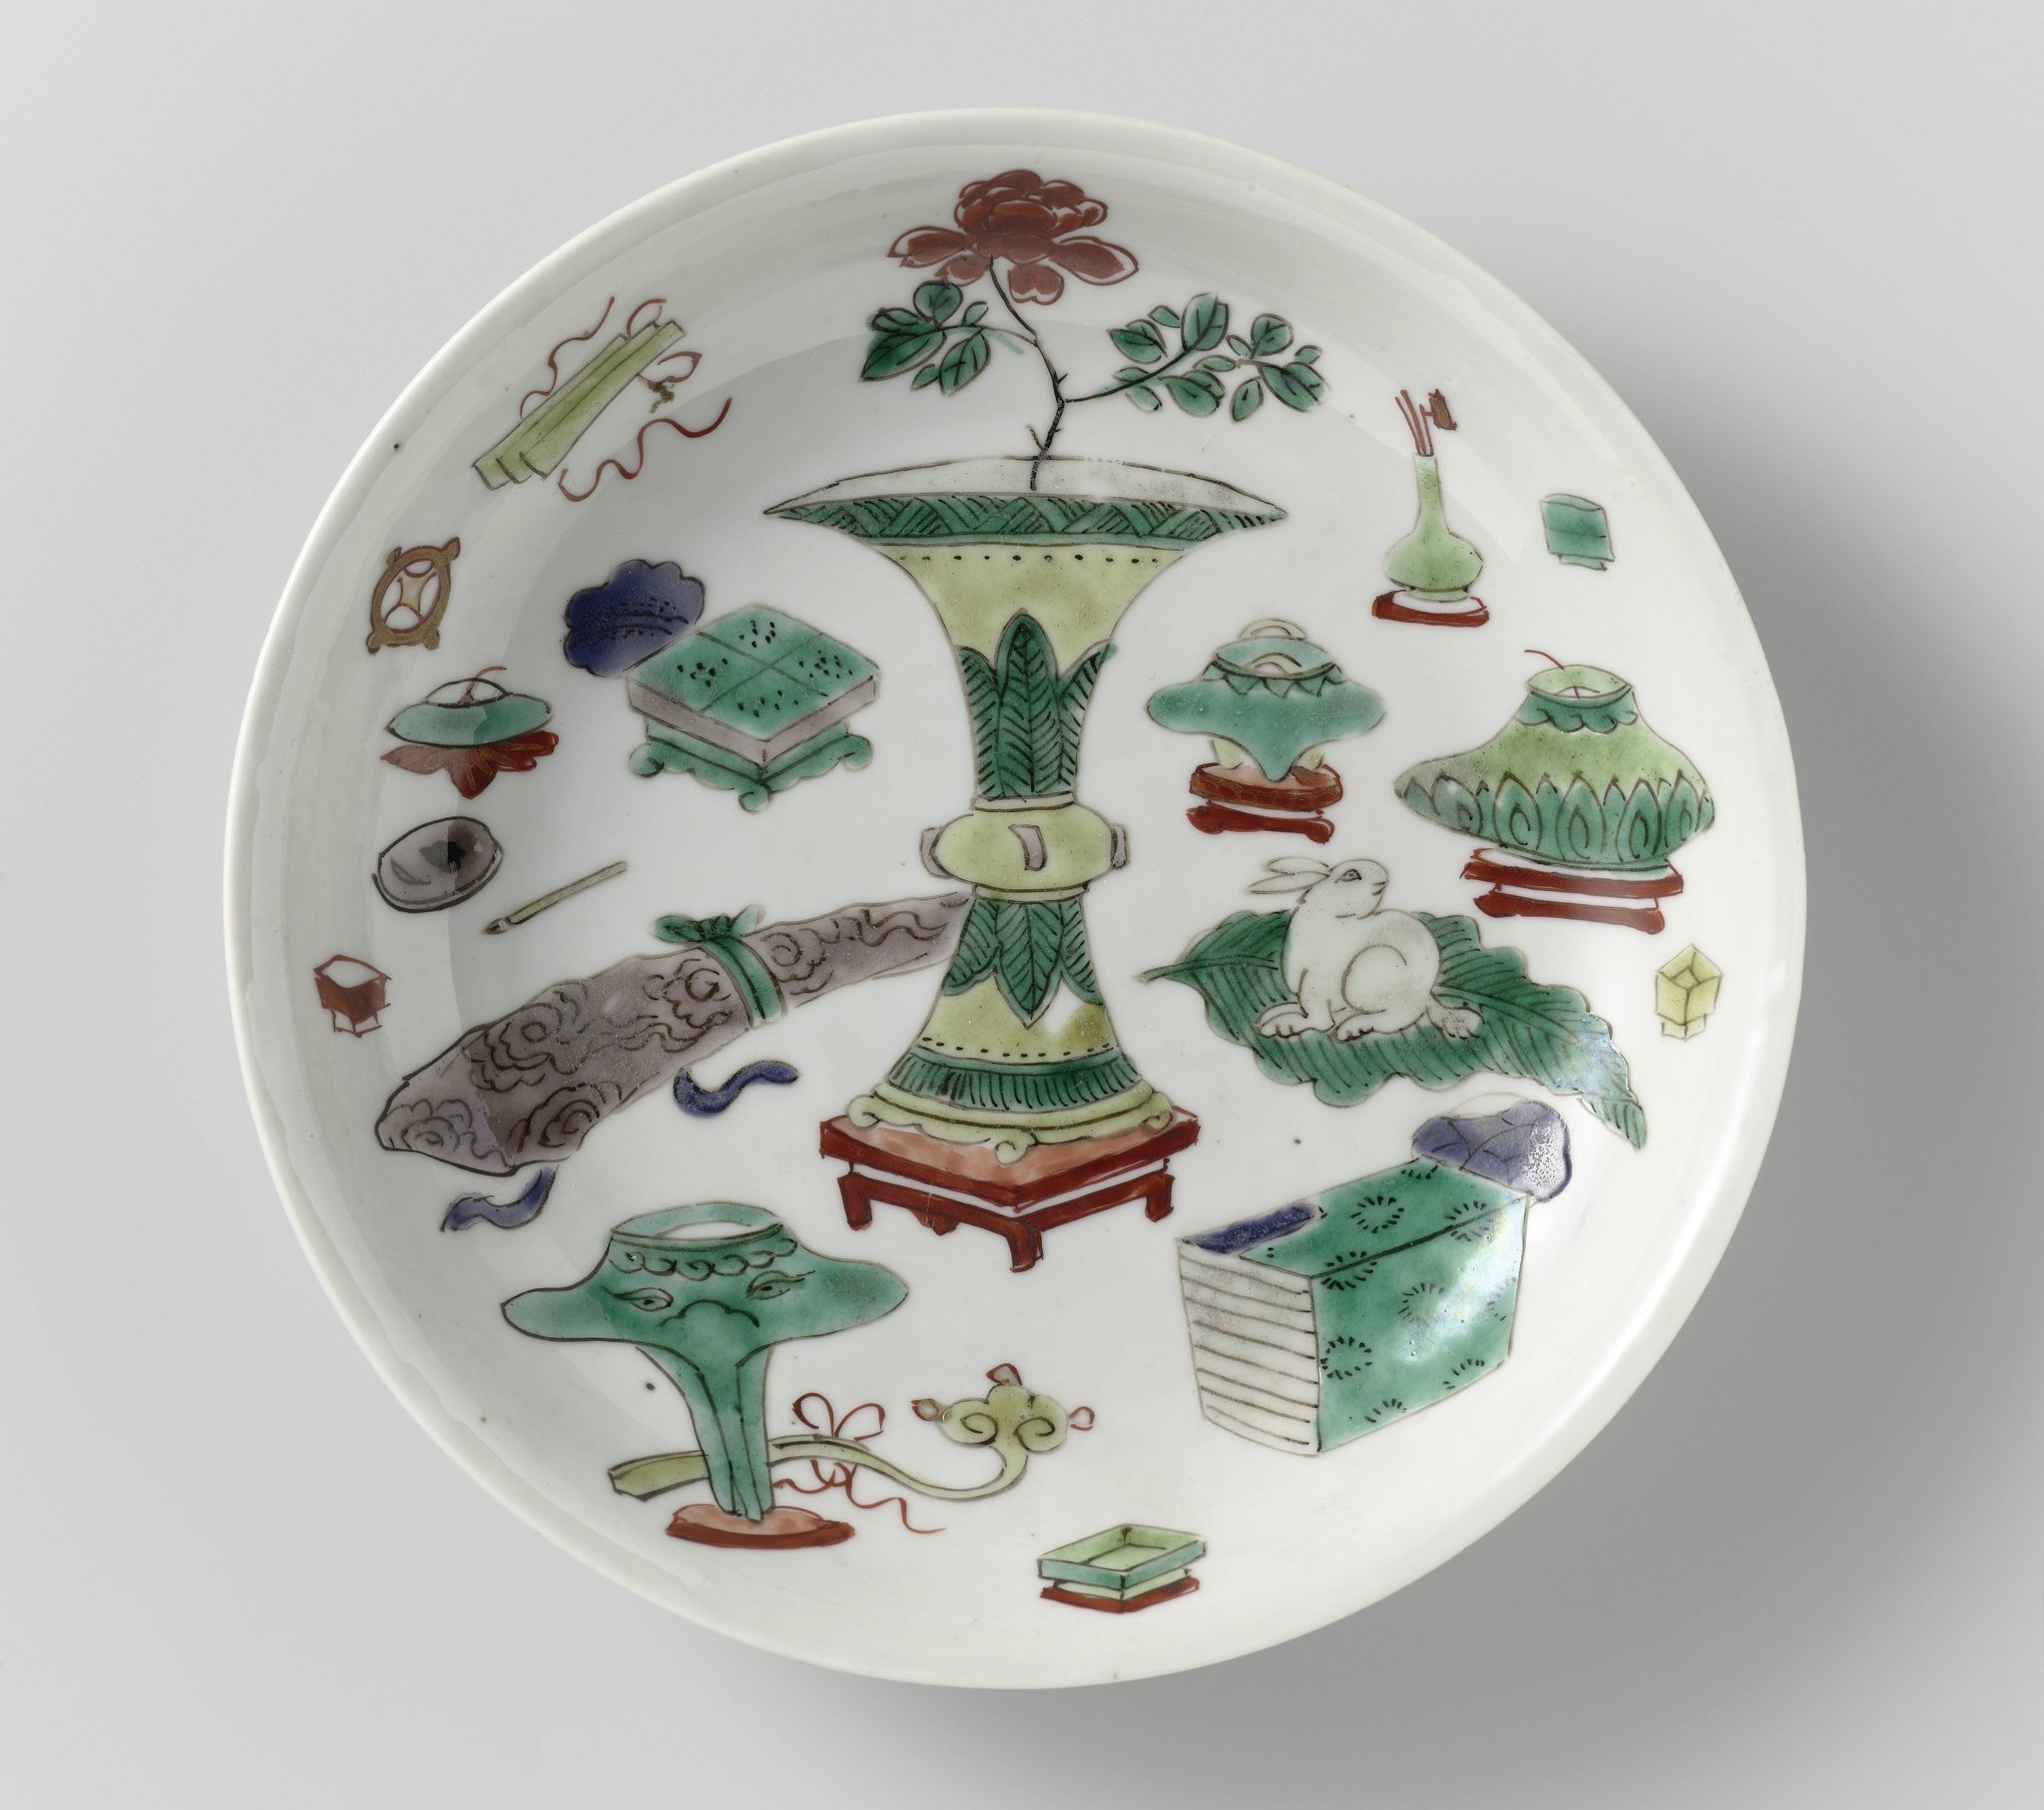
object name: platter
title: Saucer-dish with precious objects and antiquities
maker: Anonymous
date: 1700-1724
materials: cobalt, glaze, paint, porcelain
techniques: firing, turning, vitrification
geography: china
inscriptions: mark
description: Schotel met ronde wand van porselein, beschilderd in onderglazuur blauw en op het glazuur blauw, rood, groen, geel, aubergine en zwart. Op het plat Chinese antiquiteiten; de onderzijde met vier kostbaarheden. Gemerkt op de onderzijde met een zegelmerk in een dubbele cirkel. Famille verte.